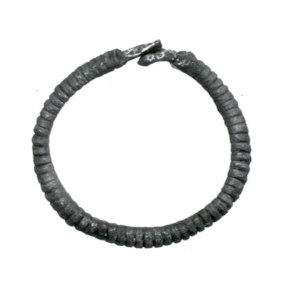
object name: bracelet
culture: sasanian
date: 201-700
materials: copper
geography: iran